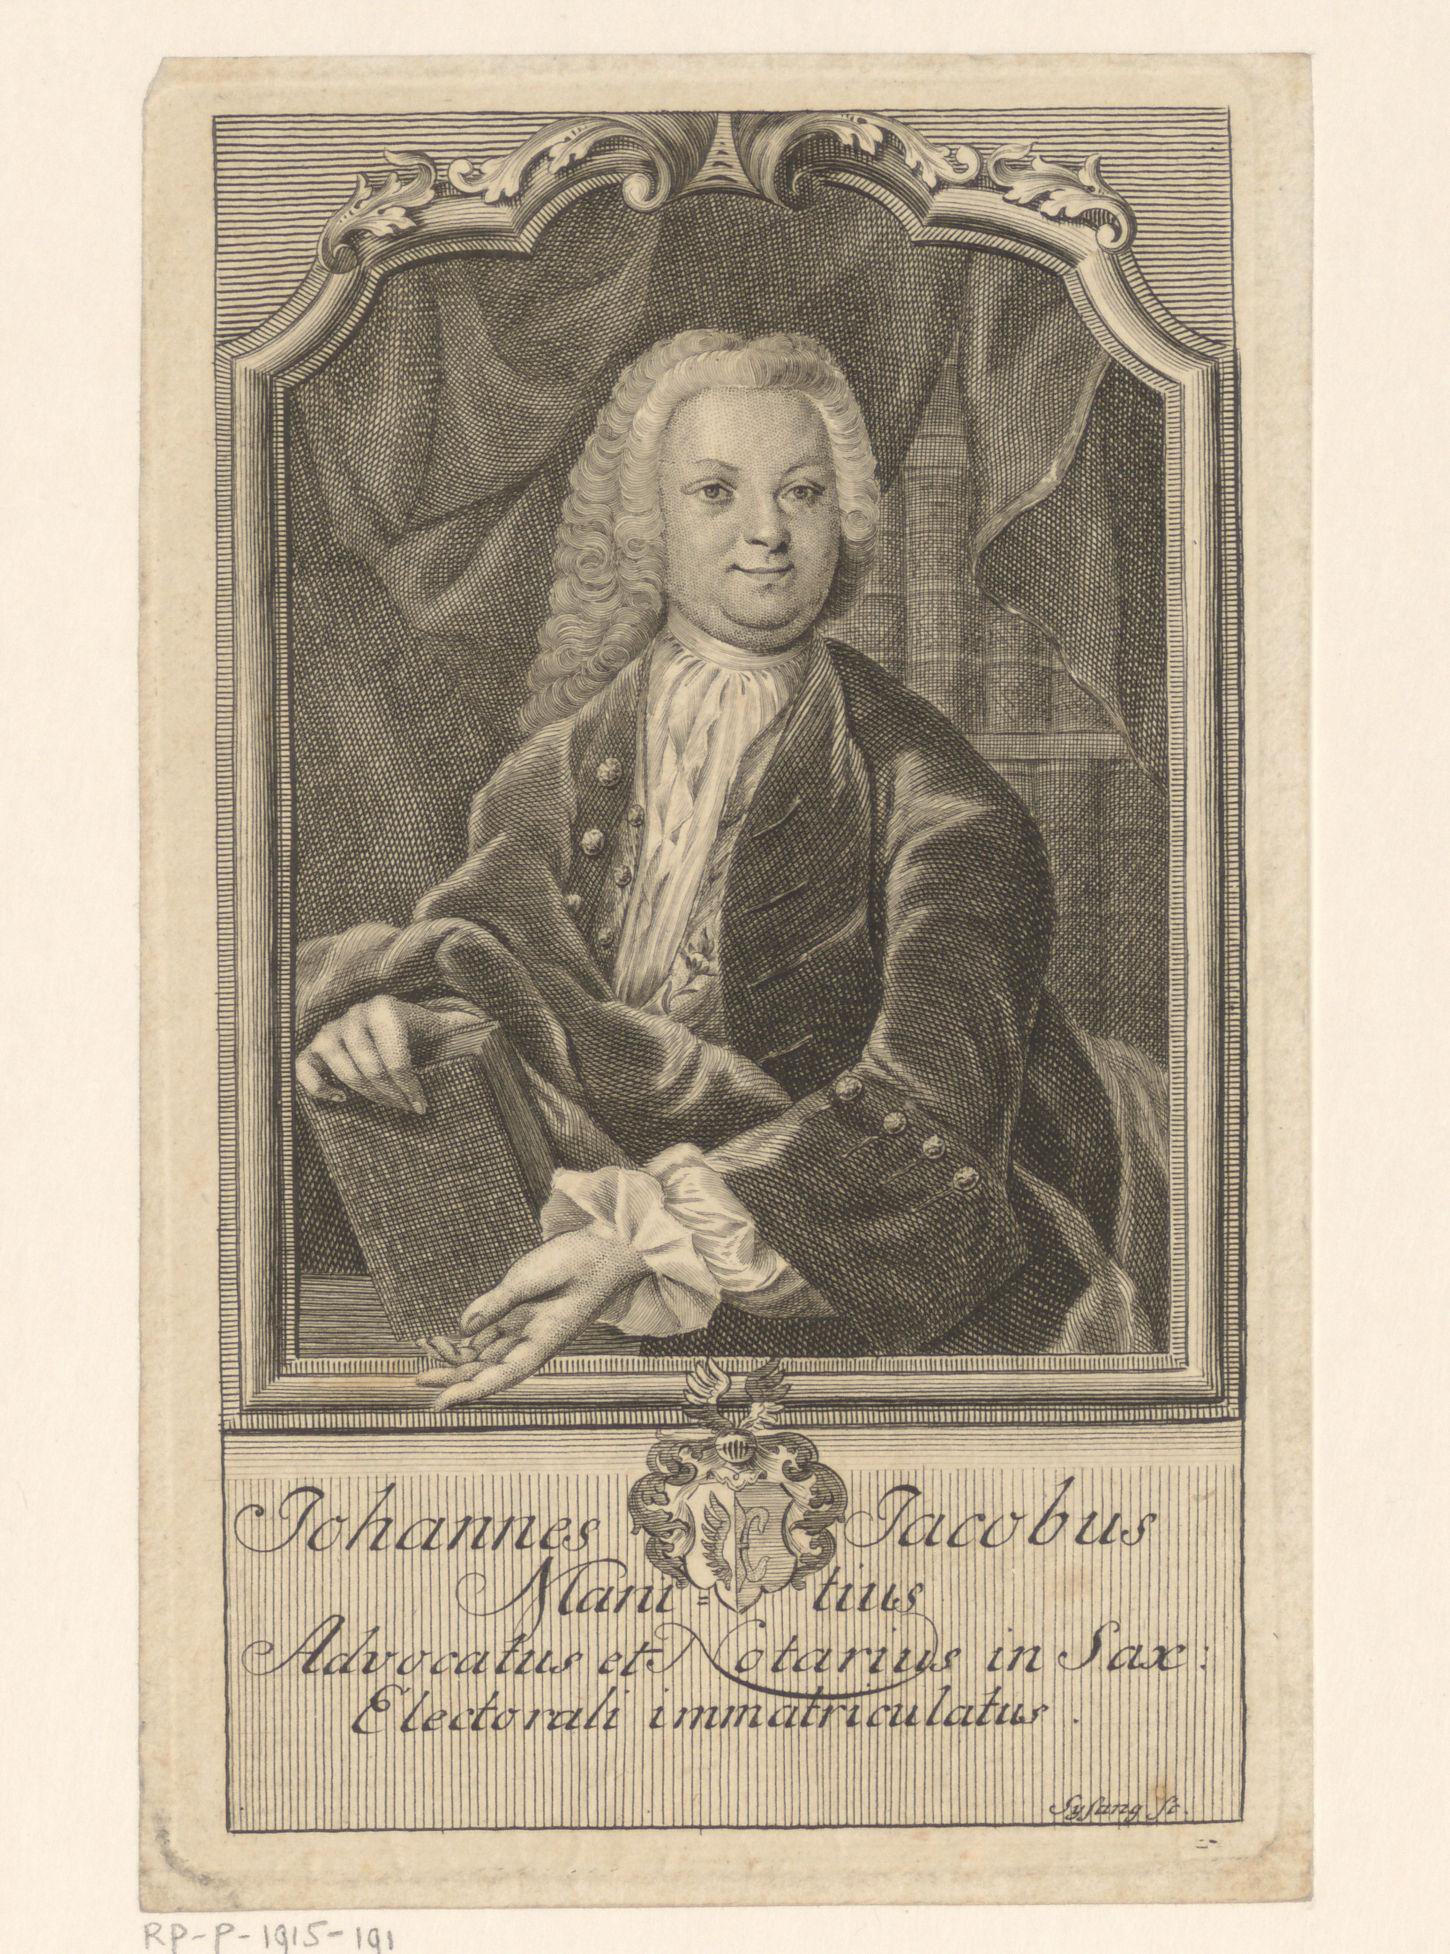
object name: print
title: Portret van Johann Jakob Manitius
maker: johann christoph sysang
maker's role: print maker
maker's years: 1703-1757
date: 1713-1757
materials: paper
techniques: engraving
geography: germany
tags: bookshelves, historical persons, armorial bearing, heraldry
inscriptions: collector's mark: Lugt 2228